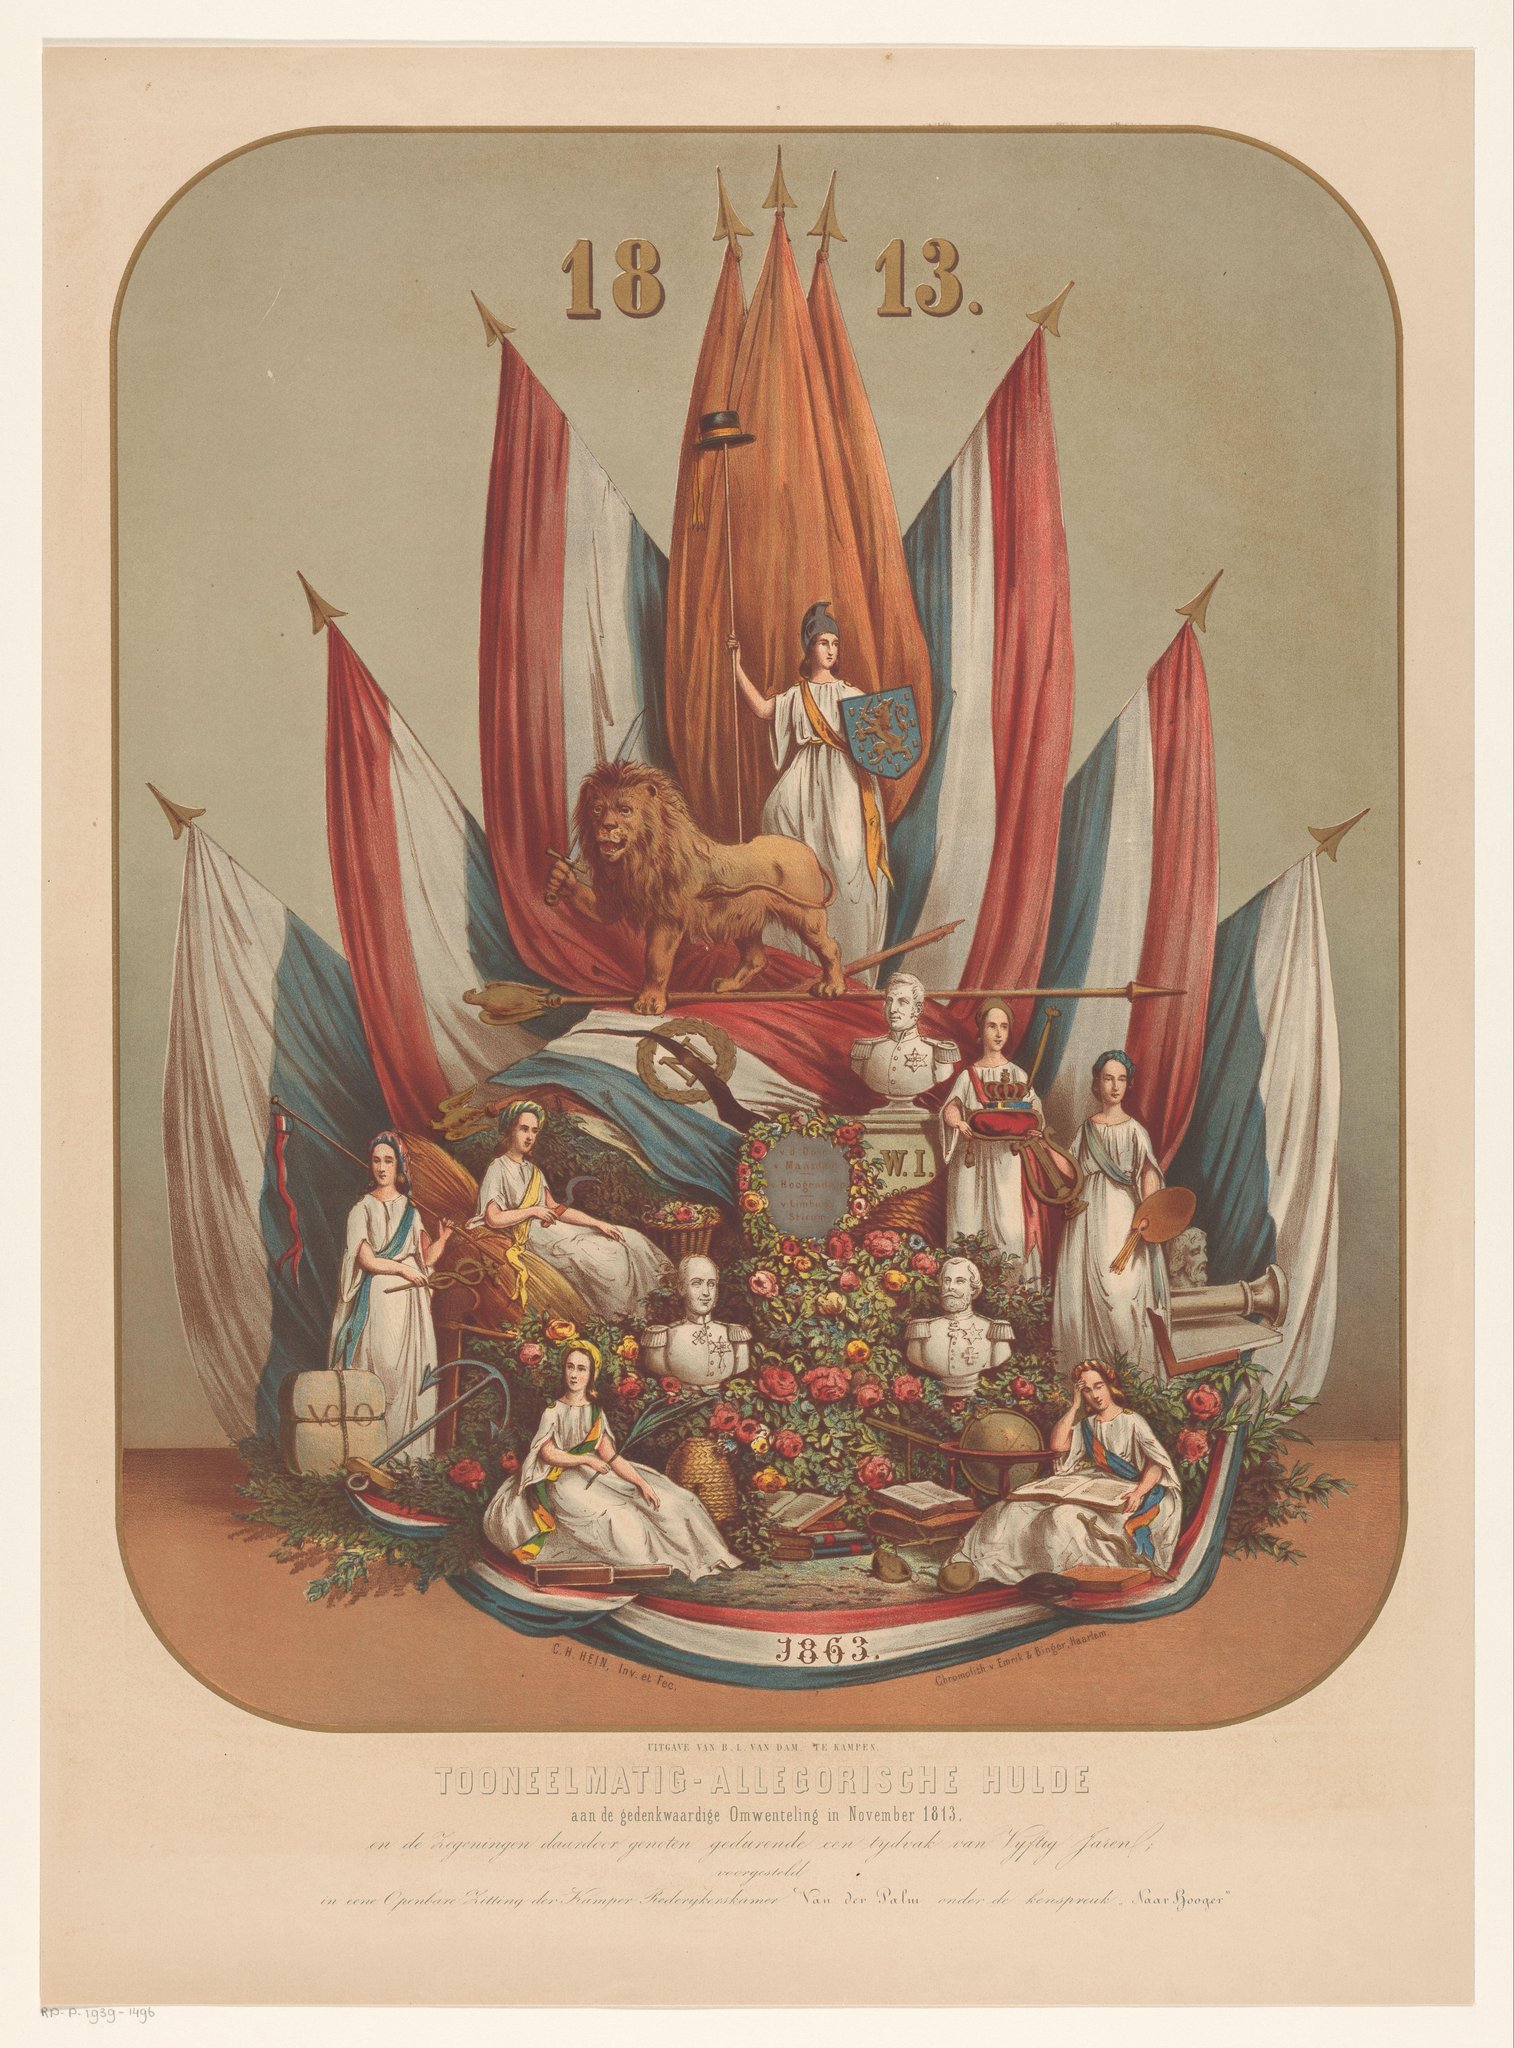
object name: print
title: Allegorische voorstelling ter herinnering aan de gedenkwaardige omwenteling in November 1813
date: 1863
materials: paper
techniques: lithograph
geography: haarlem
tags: berlin, william i of the netherlands, willem iii (koning der nederlanden), the hague, william ii of the netherlands, personifications of countries, nations, states, districts, etc., freedom, liberty; 'libertà' (ripa), flag, colours (as symbol of the state, etc.)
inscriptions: collector's mark: Lugt 2228, collector's mark: Lugt 2760, collector's mark: Lugt 2166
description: Te midden van de Nederlandse leeuw en zes vrouwelijke personificaties staan de bustes van Willem I, Willem II en Willem III. Aan de bovenzijde staat de Nederlandse maagd met vrijheidshoed en schild voor drie oranje vlaggen, geflankeerd door vier Nederlandse vlaggen en twee blauwwitte vlaggen.